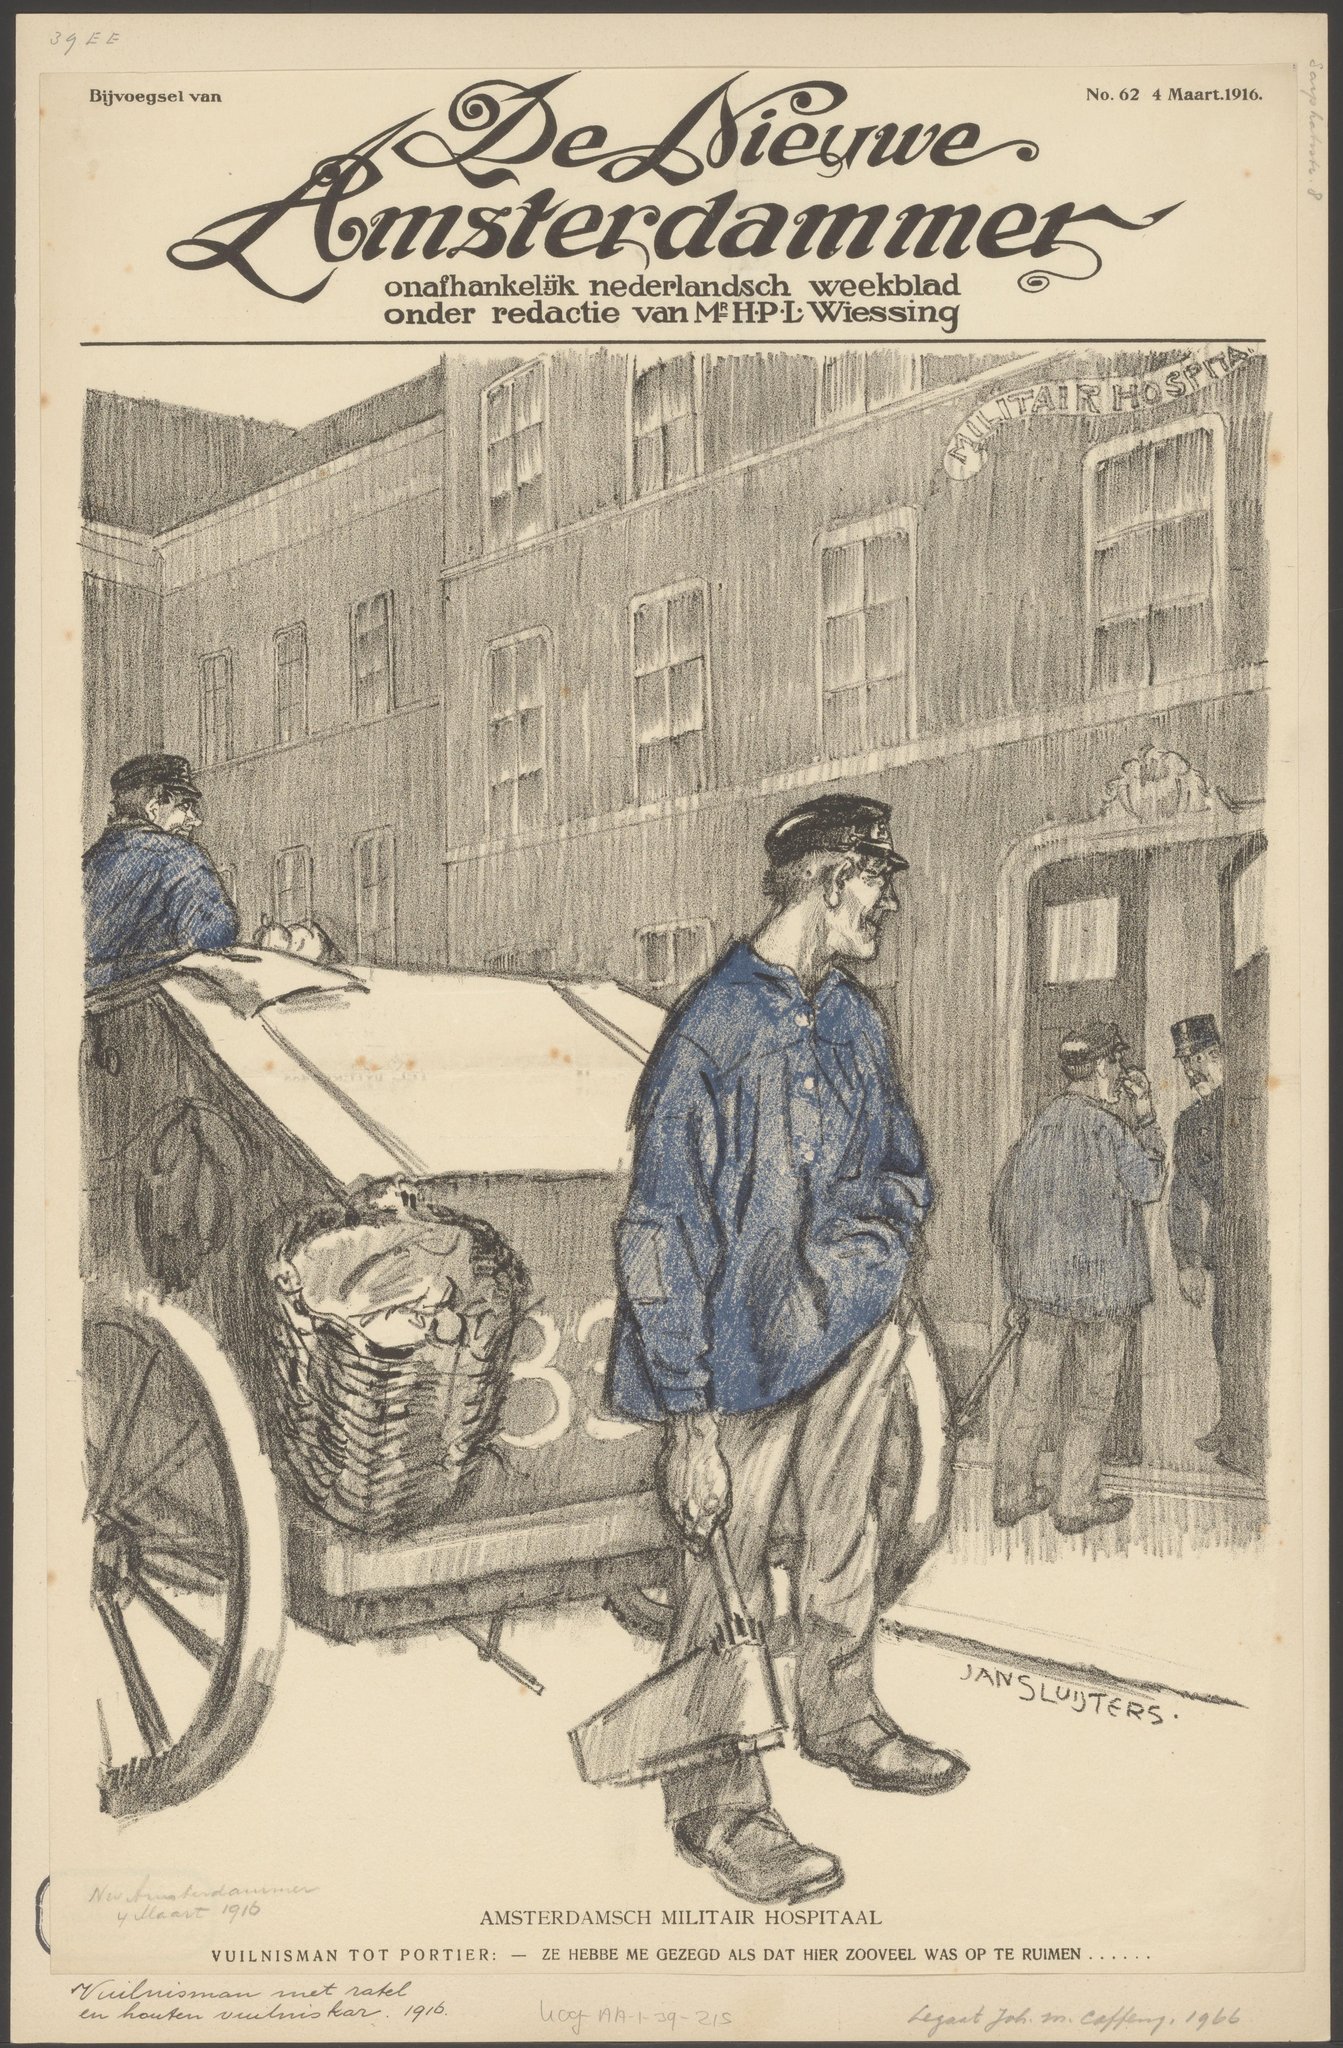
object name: cartoon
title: Amsterdamsch Militair Hospitaal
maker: jan sluijters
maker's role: draughtsman, print maker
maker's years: 1881-1957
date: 1916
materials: paper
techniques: letterpress printing, lithograph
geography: netherlands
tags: garbage collecting lorry, garbage truck, hospital, garbage collection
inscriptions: collector's mark: Lugt 1641b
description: Onderwerpsrubriek binnen de Atlas Amsterdam: Armwezen en liefdadige instellingen: V. Ziekenhuizen: Ver. voor Ziekenverpleging aan de Prinsengracht.